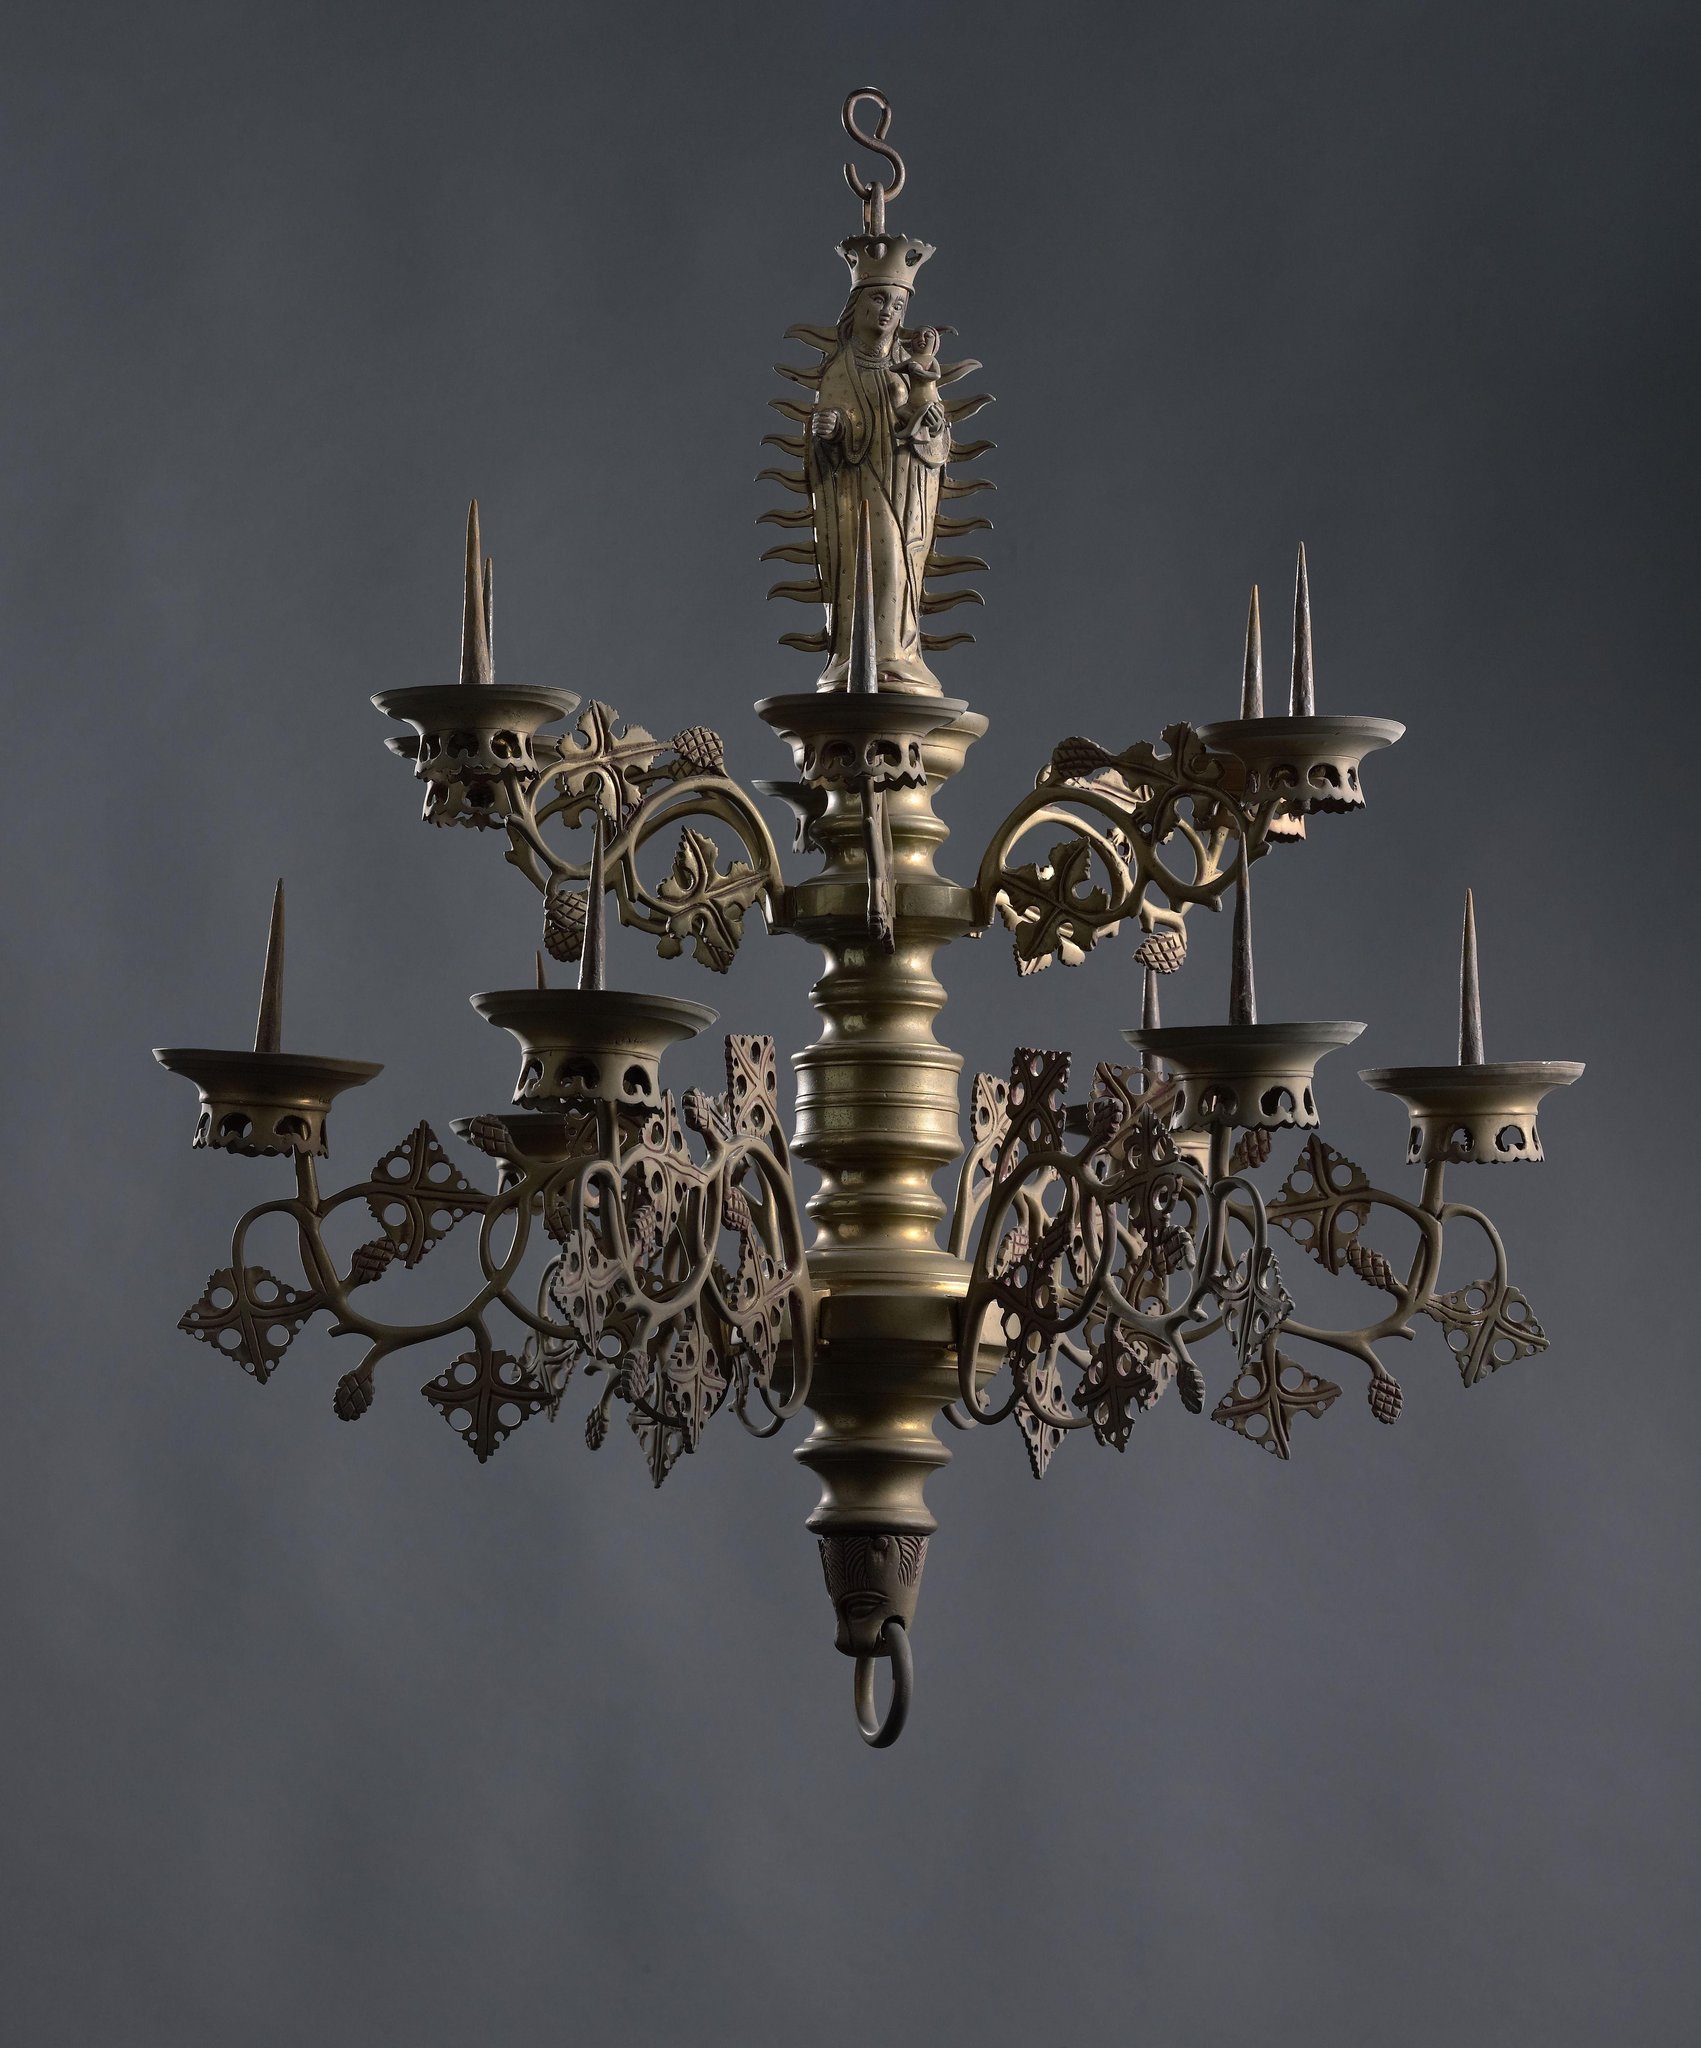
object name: chandelier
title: Arm met kaarsenhouder van kaarsenkroon van twee hoogten met ieder zes armen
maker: Anonymous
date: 1475-1500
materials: brass, iron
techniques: casting, metalworking, forging, screwed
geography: southern netherlands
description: Kaarsenarm behorende bij een kaarsenkroon van twee hoogten met Mariafiguur bovenaan. De arm is twee maal gebogen en is versierd met vier druiventrossen en vijf wingerdbladeren. De ronde vetvanger heeft aan de onderkant opengewerkte, gekartelde verticaal geplaatste randen, ter maskering van de bevestiging op de arm. Dit geschiedt door een ronde ijzeren pin, die in het einde van de arm is geschroefd. Dit is de vierde arm van de onderste ring, genummerd met 4 verticale inkepingen. De vetvanger is genummerd met 4 verticale inkepingen.